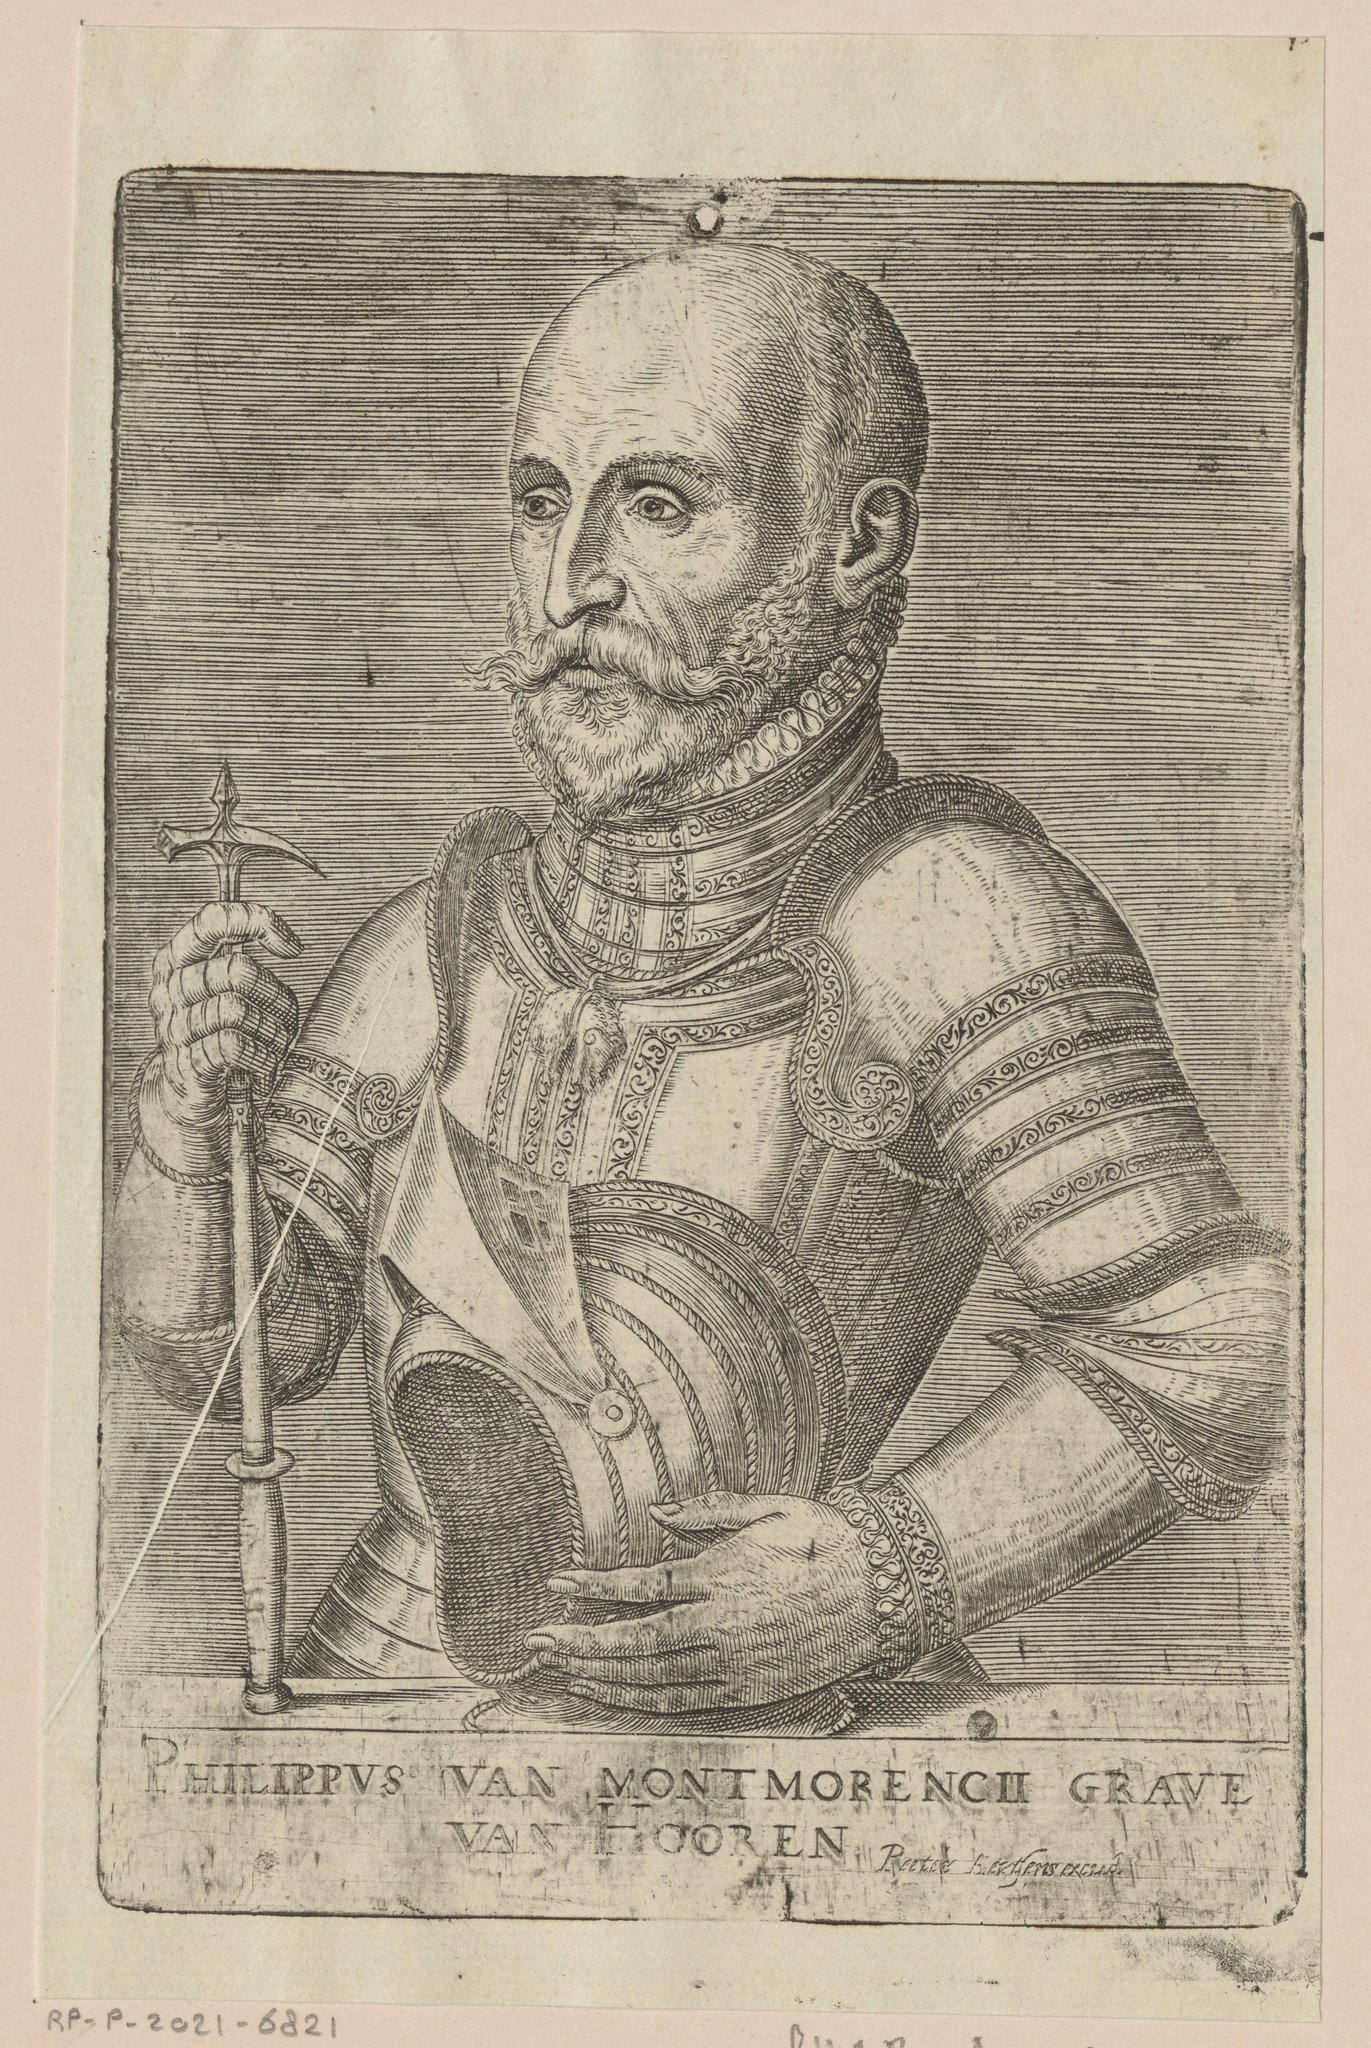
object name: print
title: Portret van Filips van Montmorency, graaf van Horne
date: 1700-1799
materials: paper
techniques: engraving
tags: brussels, helmet, armour, historical persons, knighthood order of the golden fleece